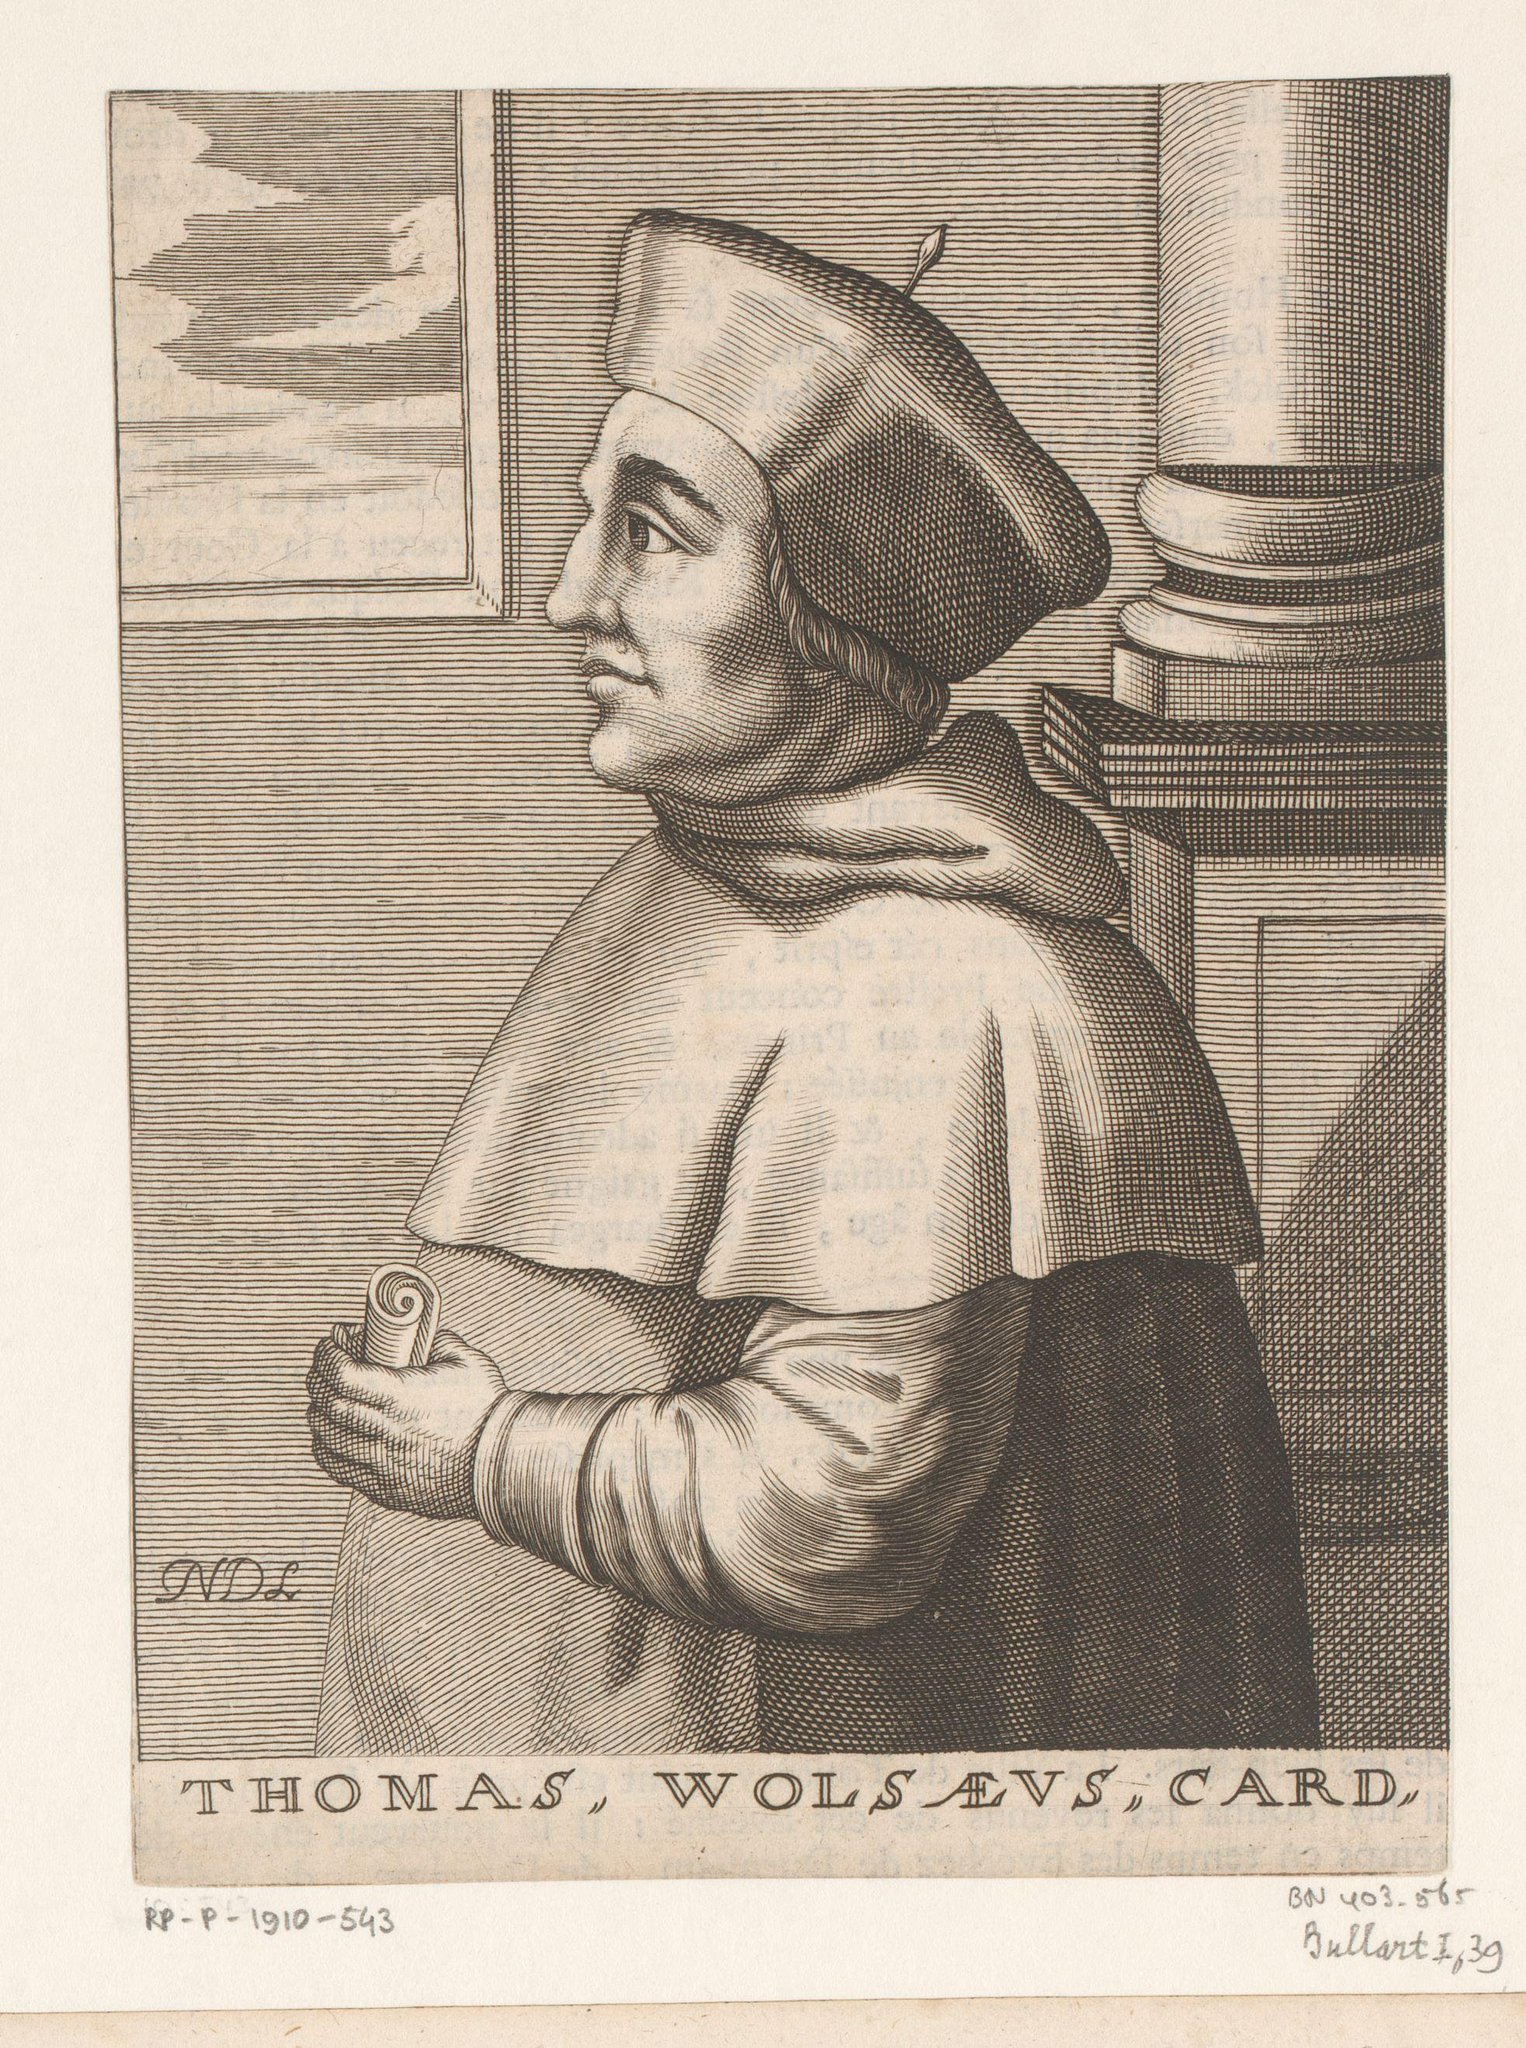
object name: print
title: Portret van Thomas Wolsey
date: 1682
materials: paper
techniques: engraving, letterpress printing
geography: brussels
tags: cardinal, historical persons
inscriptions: collector's mark: Lugt 2228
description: Prent gebruikt voor: Bullart, Isaac. Académie des Sciences et Arts contenant les vies et éloges his. des hommes illustres qui ont excellé en ces professions depuis environ quatre siècles. Brussel: François Foppens, 1682. Het boek werd in 1682 eveneens in Amsterdam uitgegeven door de erfgenamen van Daniel Elzevier. Ieder portret betreft een illustratie bij de biografie van een kunstenaar of geleerde. De meeste portretten werden door Nicolas de Larmessin vervaardigd (162), 93 door De Boulonois en een derde door ongeïdentificeerde prentmakers. Dit betreft een illustratie op p. 39, deel II.